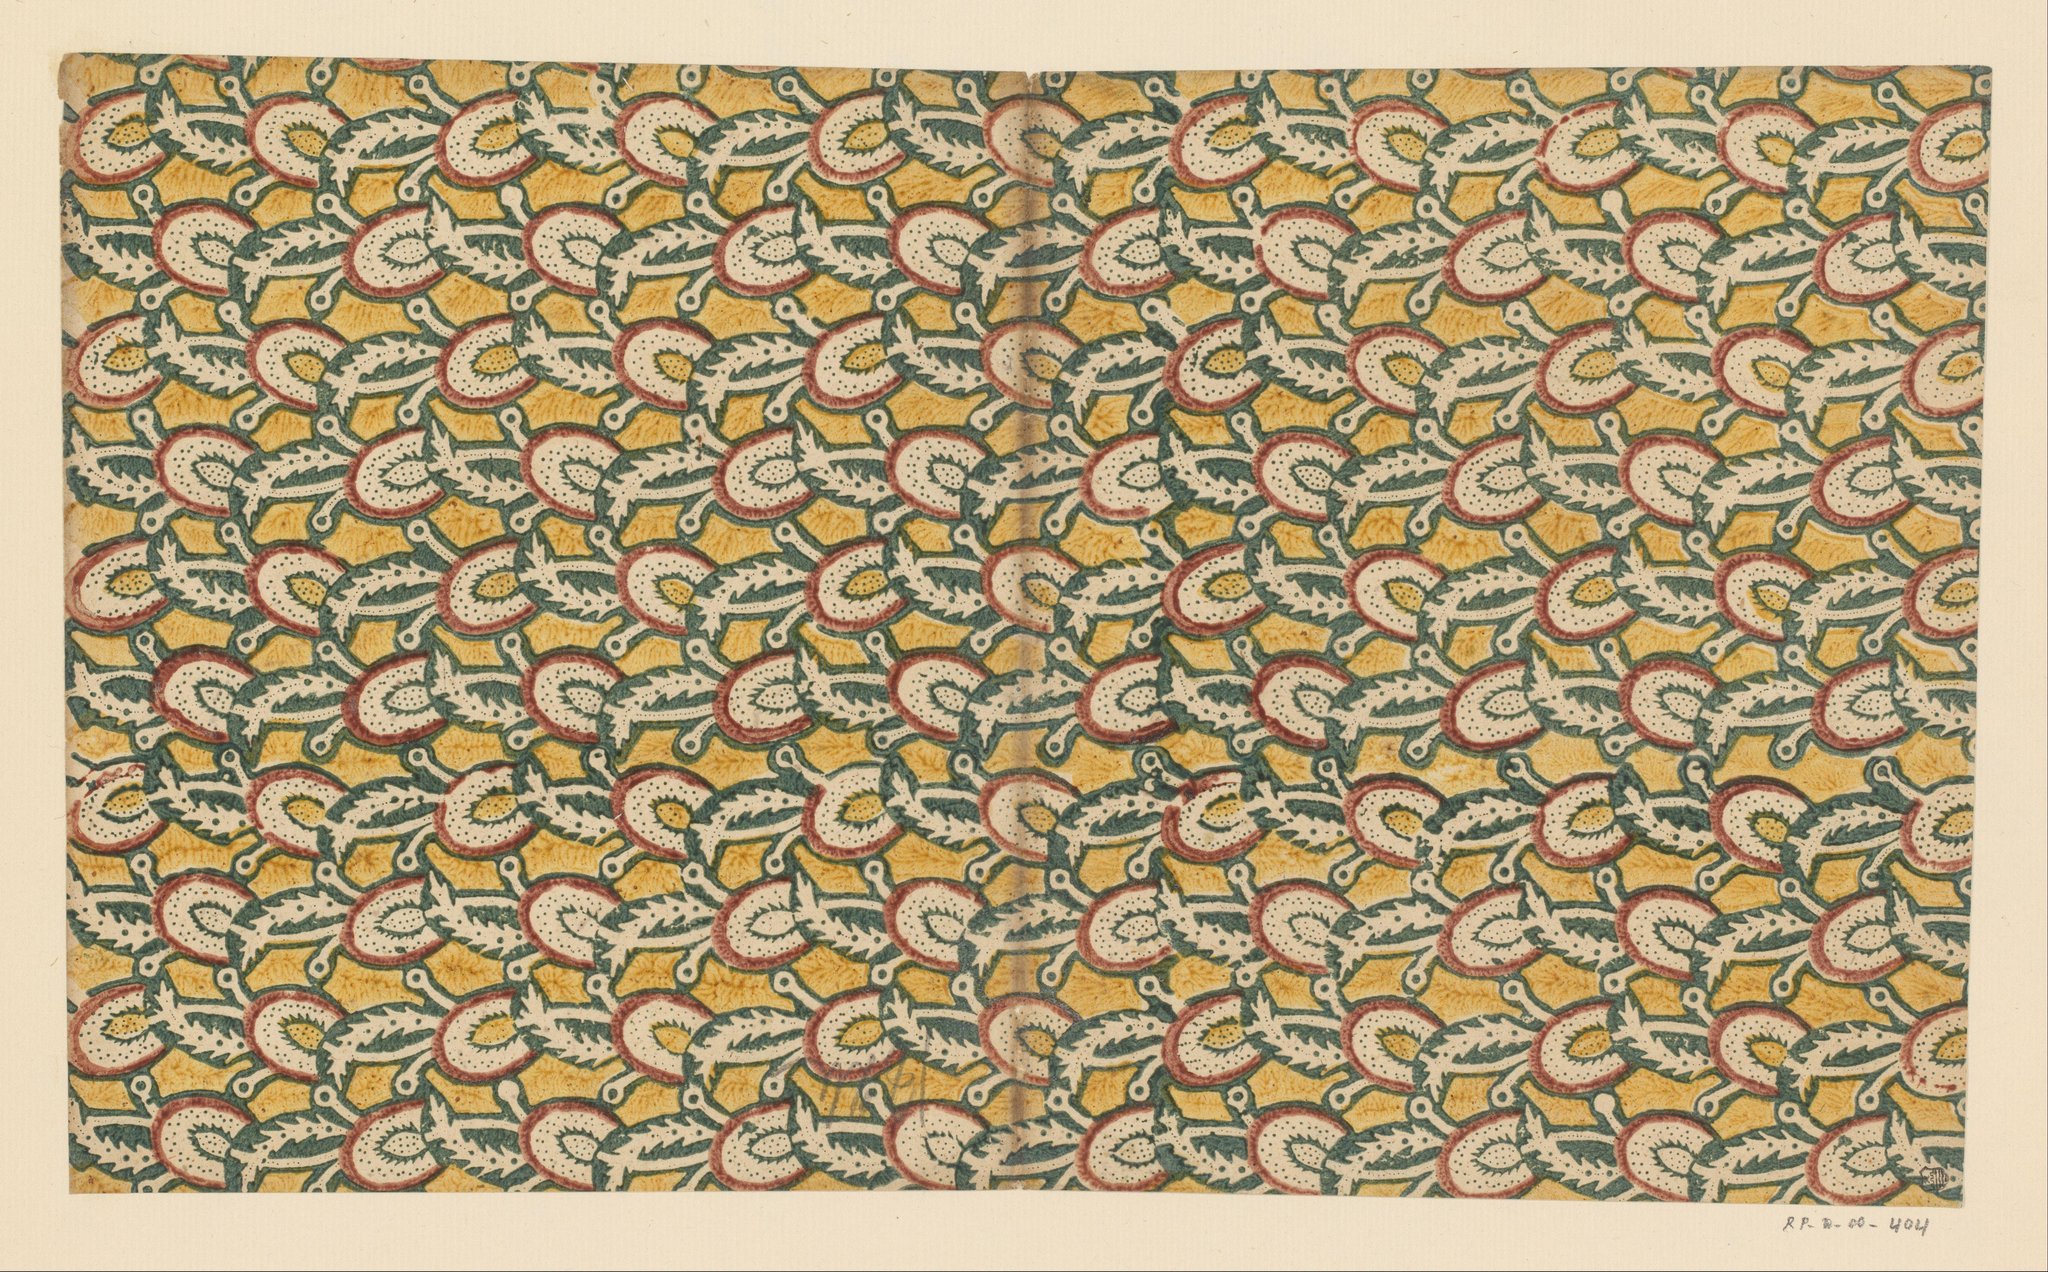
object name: printed paper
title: Blad met banenpatroon van uitgespaard blad en ovaal motief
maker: Anonymous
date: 1700-1850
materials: paper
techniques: printing block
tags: ornament derived from plant forms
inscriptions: collector's mark: Lugt 2760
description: Blad met banenpatroon van uitgespaard verbonden blad en rond motief. Gebruikt als omslag.